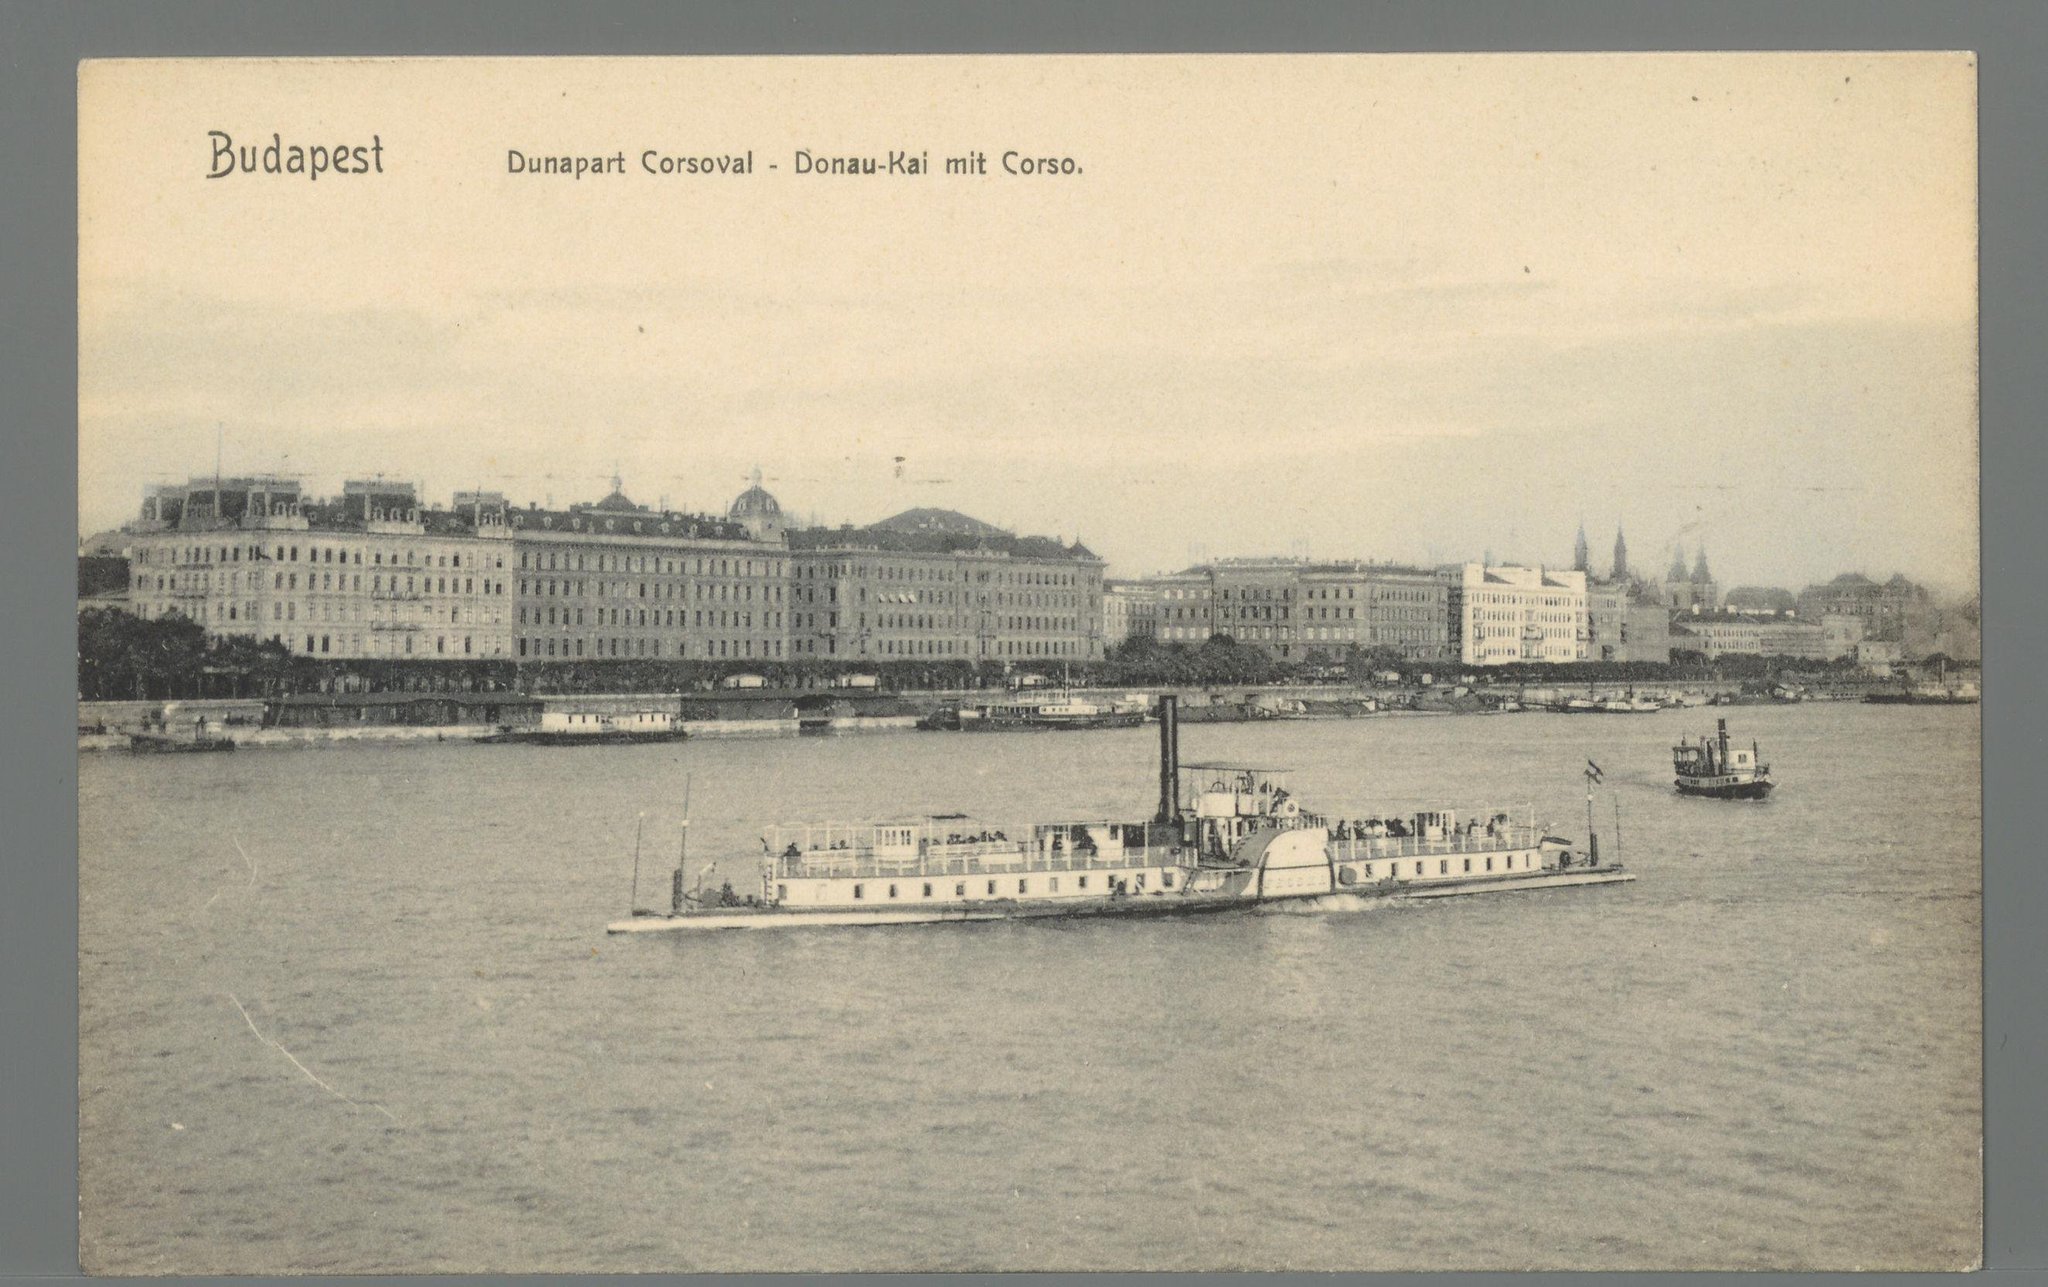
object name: ansichtkaart, prentbriefkaart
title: Budapest. Dunapart Corsoval / Donau-Kai mit Corso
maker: Anonymous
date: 1905-1930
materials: cardboard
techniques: photograph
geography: vienna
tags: canals, waters (in city), quay, steamship, motorship